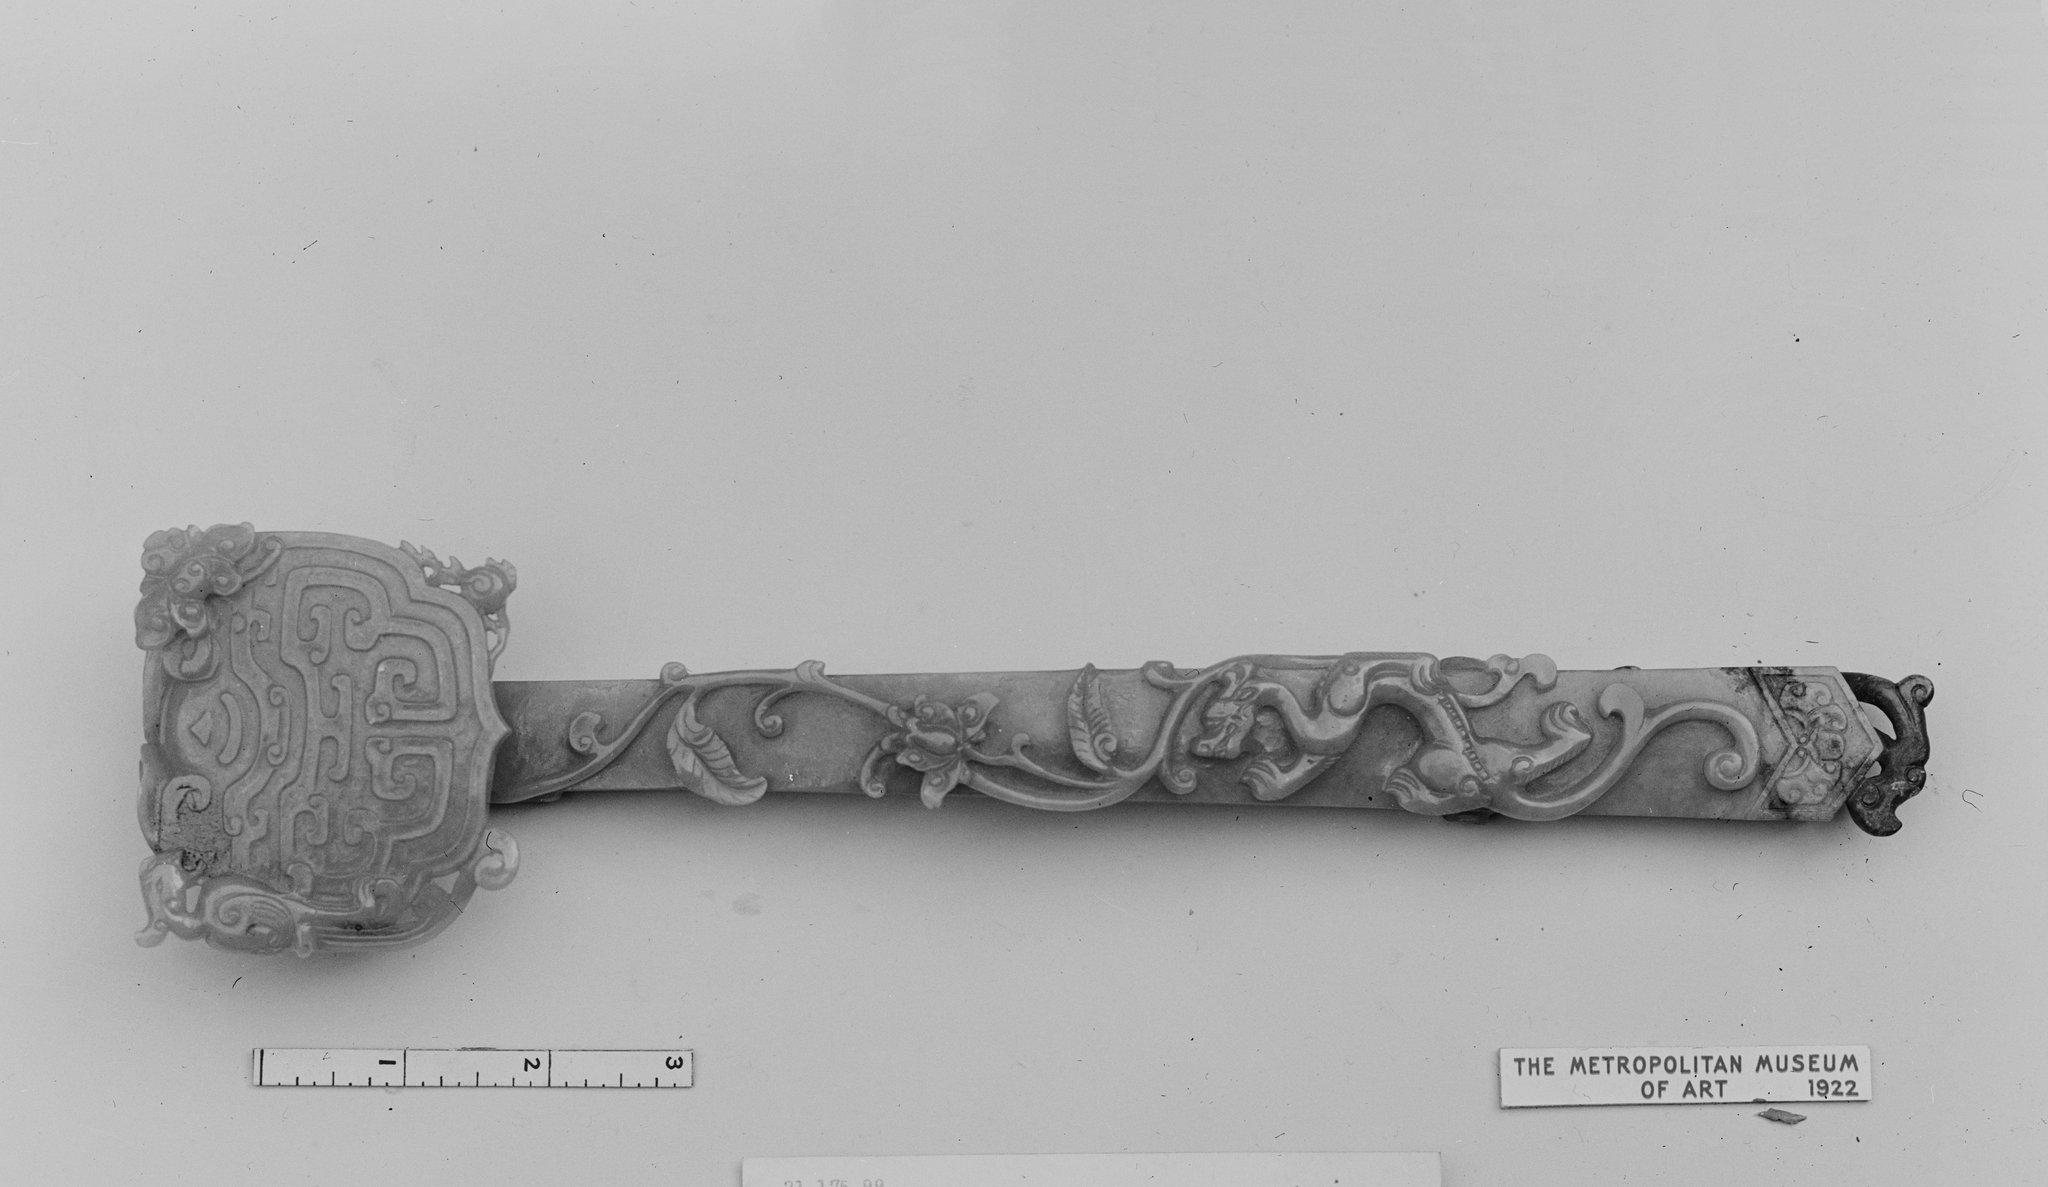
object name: scepter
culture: chinese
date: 1736-1795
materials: jade